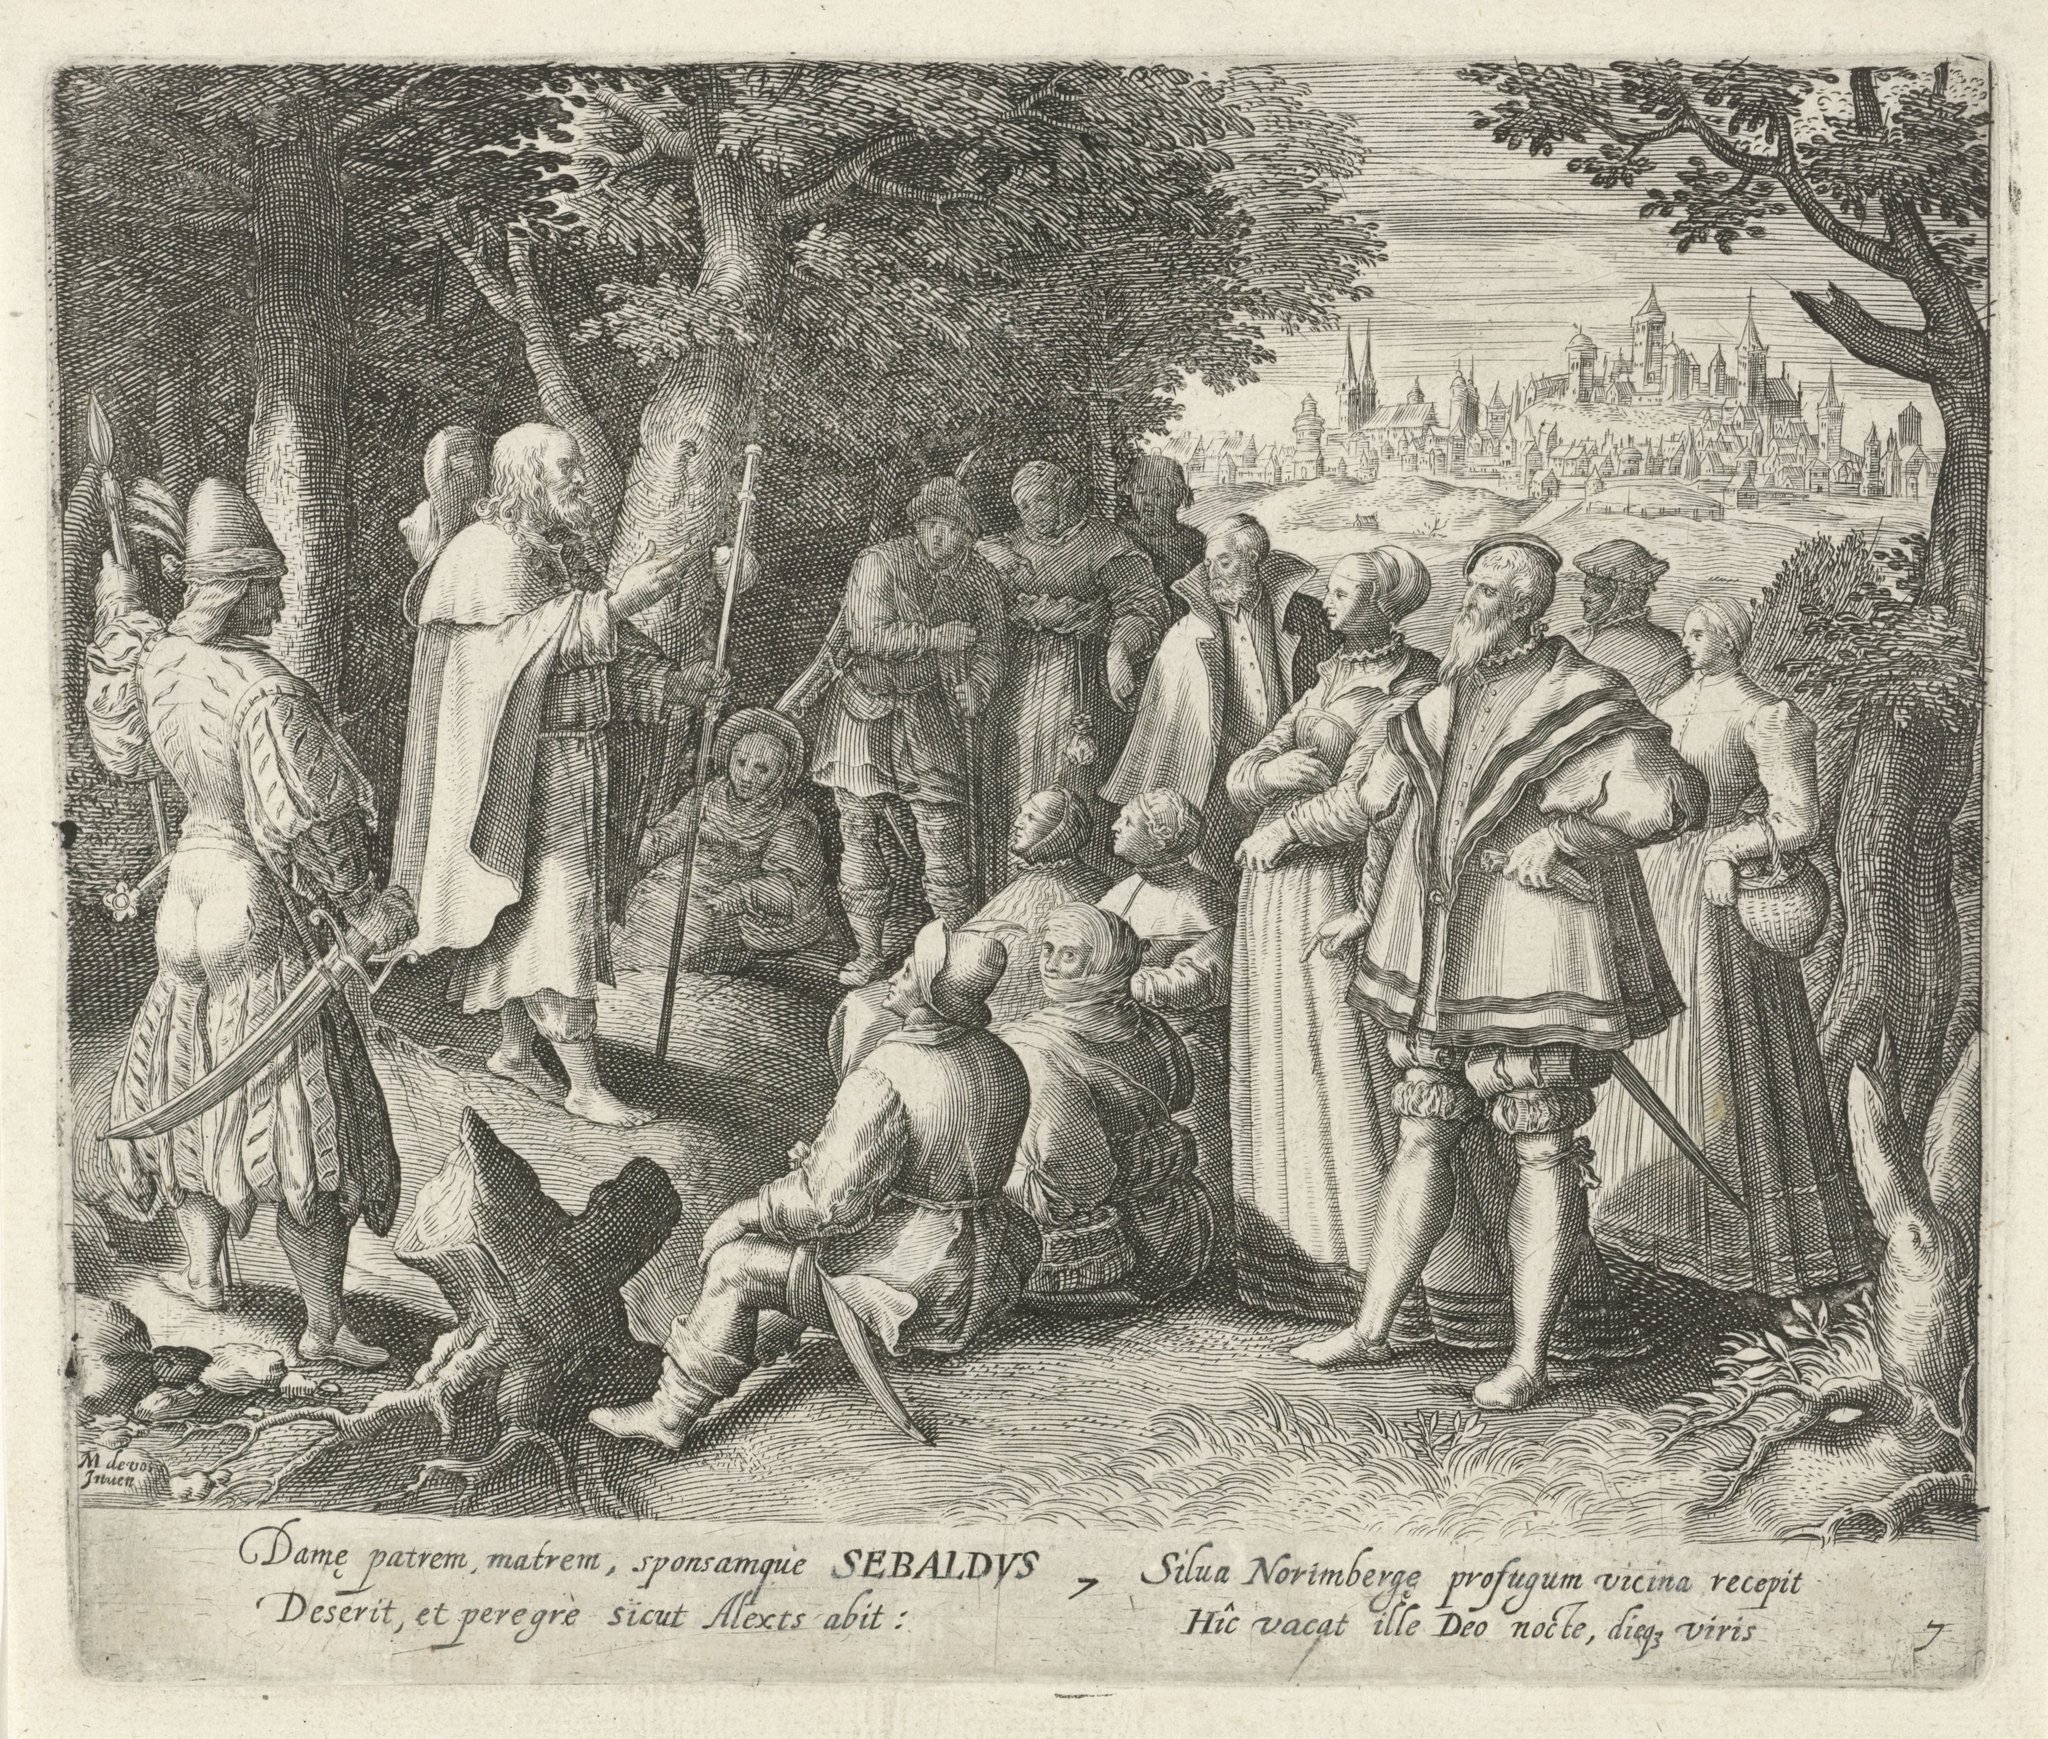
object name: print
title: H. Sebaldus van Neurenberg als kluizenaar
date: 1580-1625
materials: paper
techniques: engraving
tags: the hermit and pilgrim sebald of nuremberg; possible attributes: crown (at his feet or on book), model of church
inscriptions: collector's mark: Lugt 2228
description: De heilige Sebaldus, als kluizenaar gevestigd bij Neurenberg, predikend tot een groep bijeengekomen toehoorders. In de marge een onderschrift in Latijn.